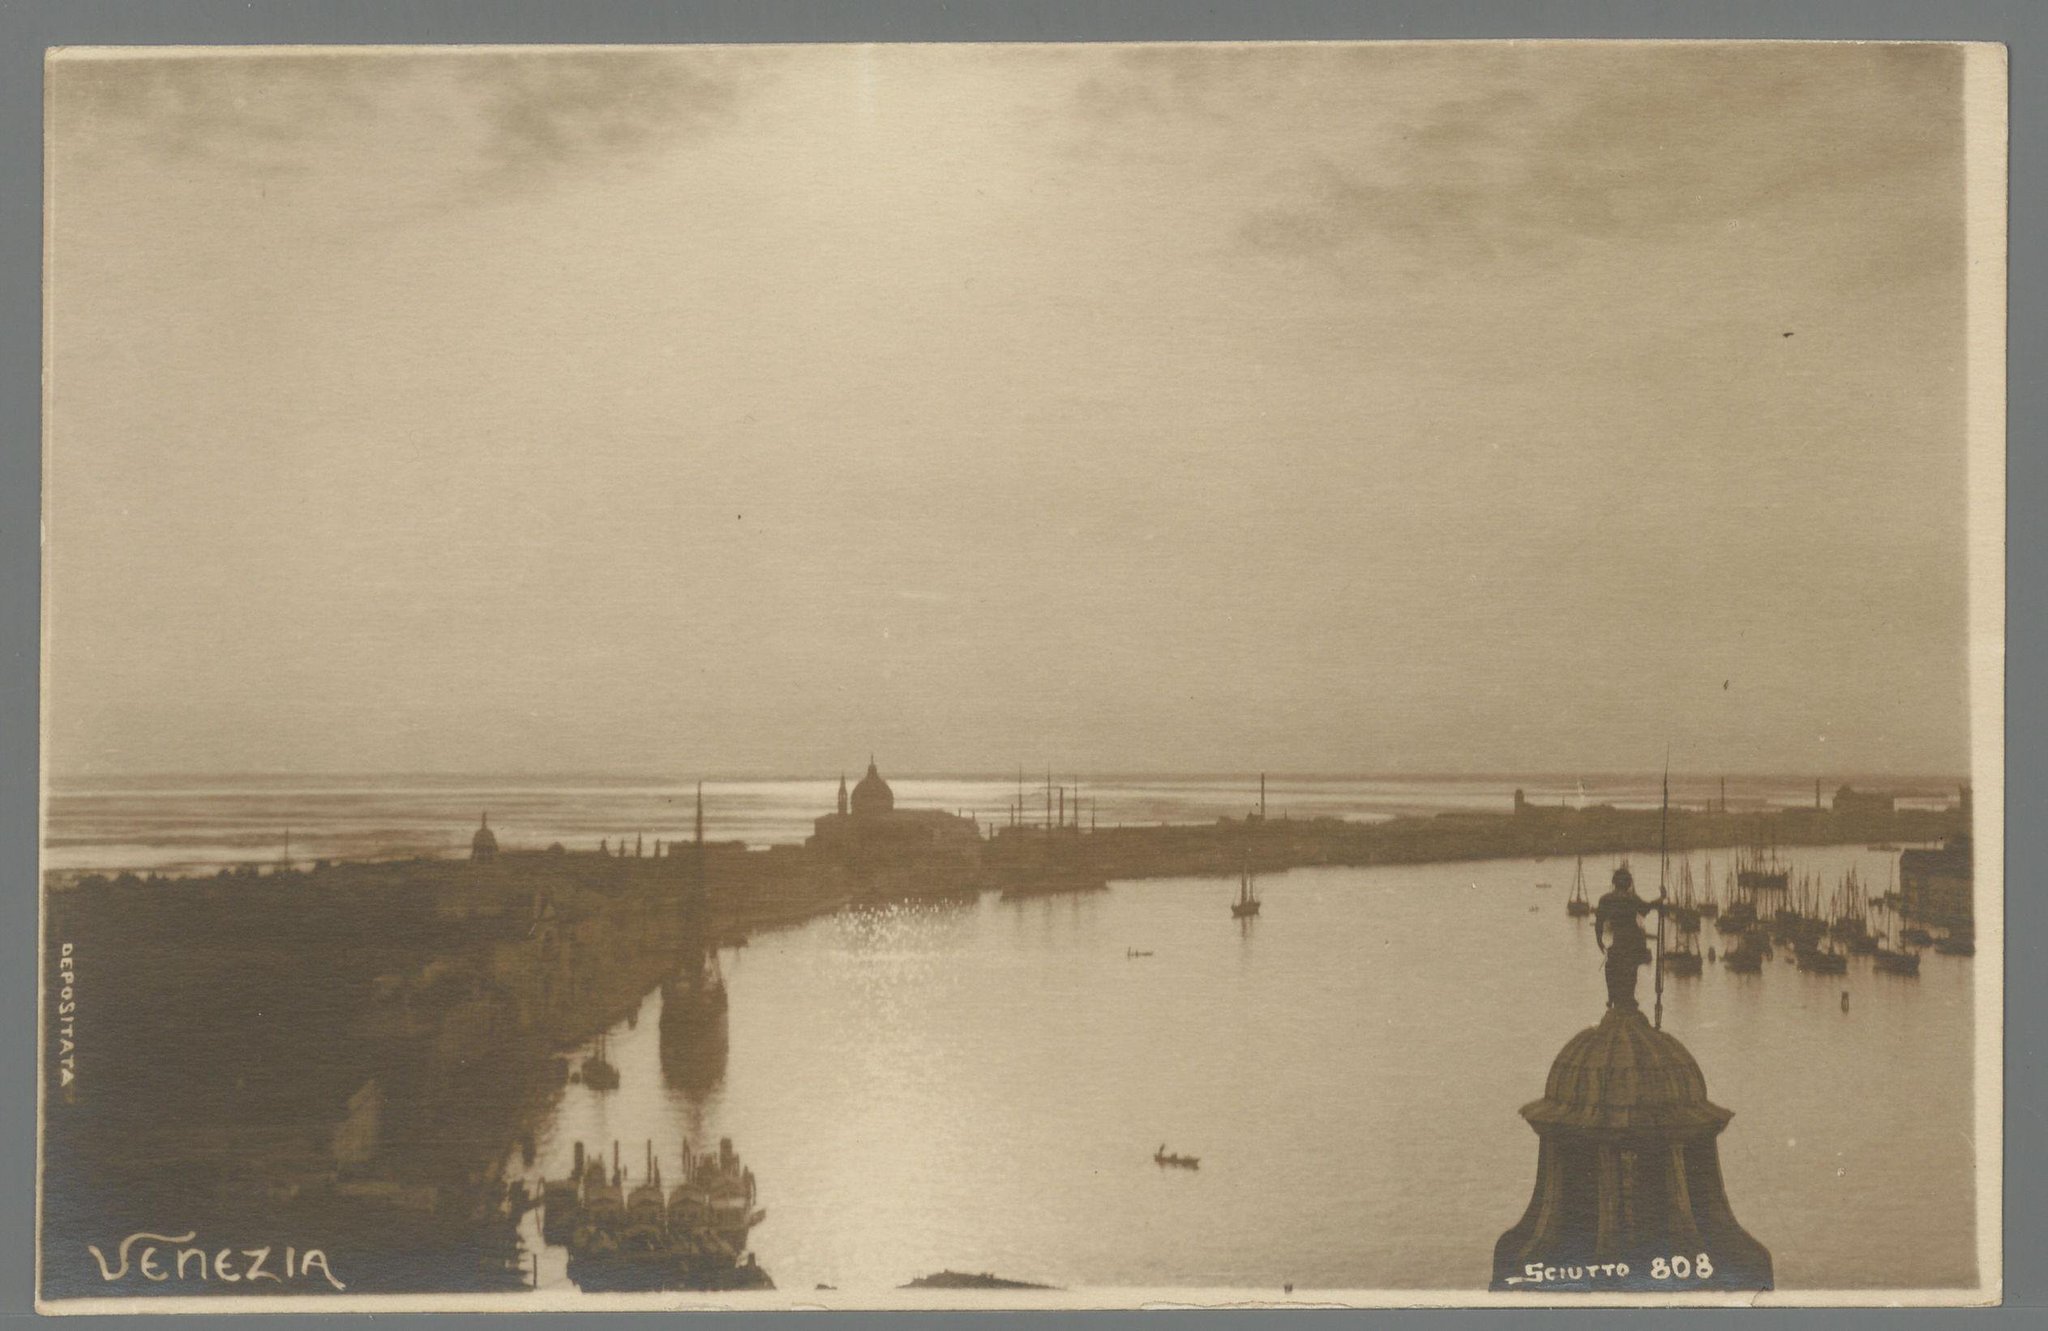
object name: photograph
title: Venezia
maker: tensi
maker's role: publisher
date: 1906-1920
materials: photographic support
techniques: photography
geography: venice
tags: landscapes with waters, waterscapes, seascapes (in the temperate zone), church (exterior), ships (in general) - cc - more than one ship, venice